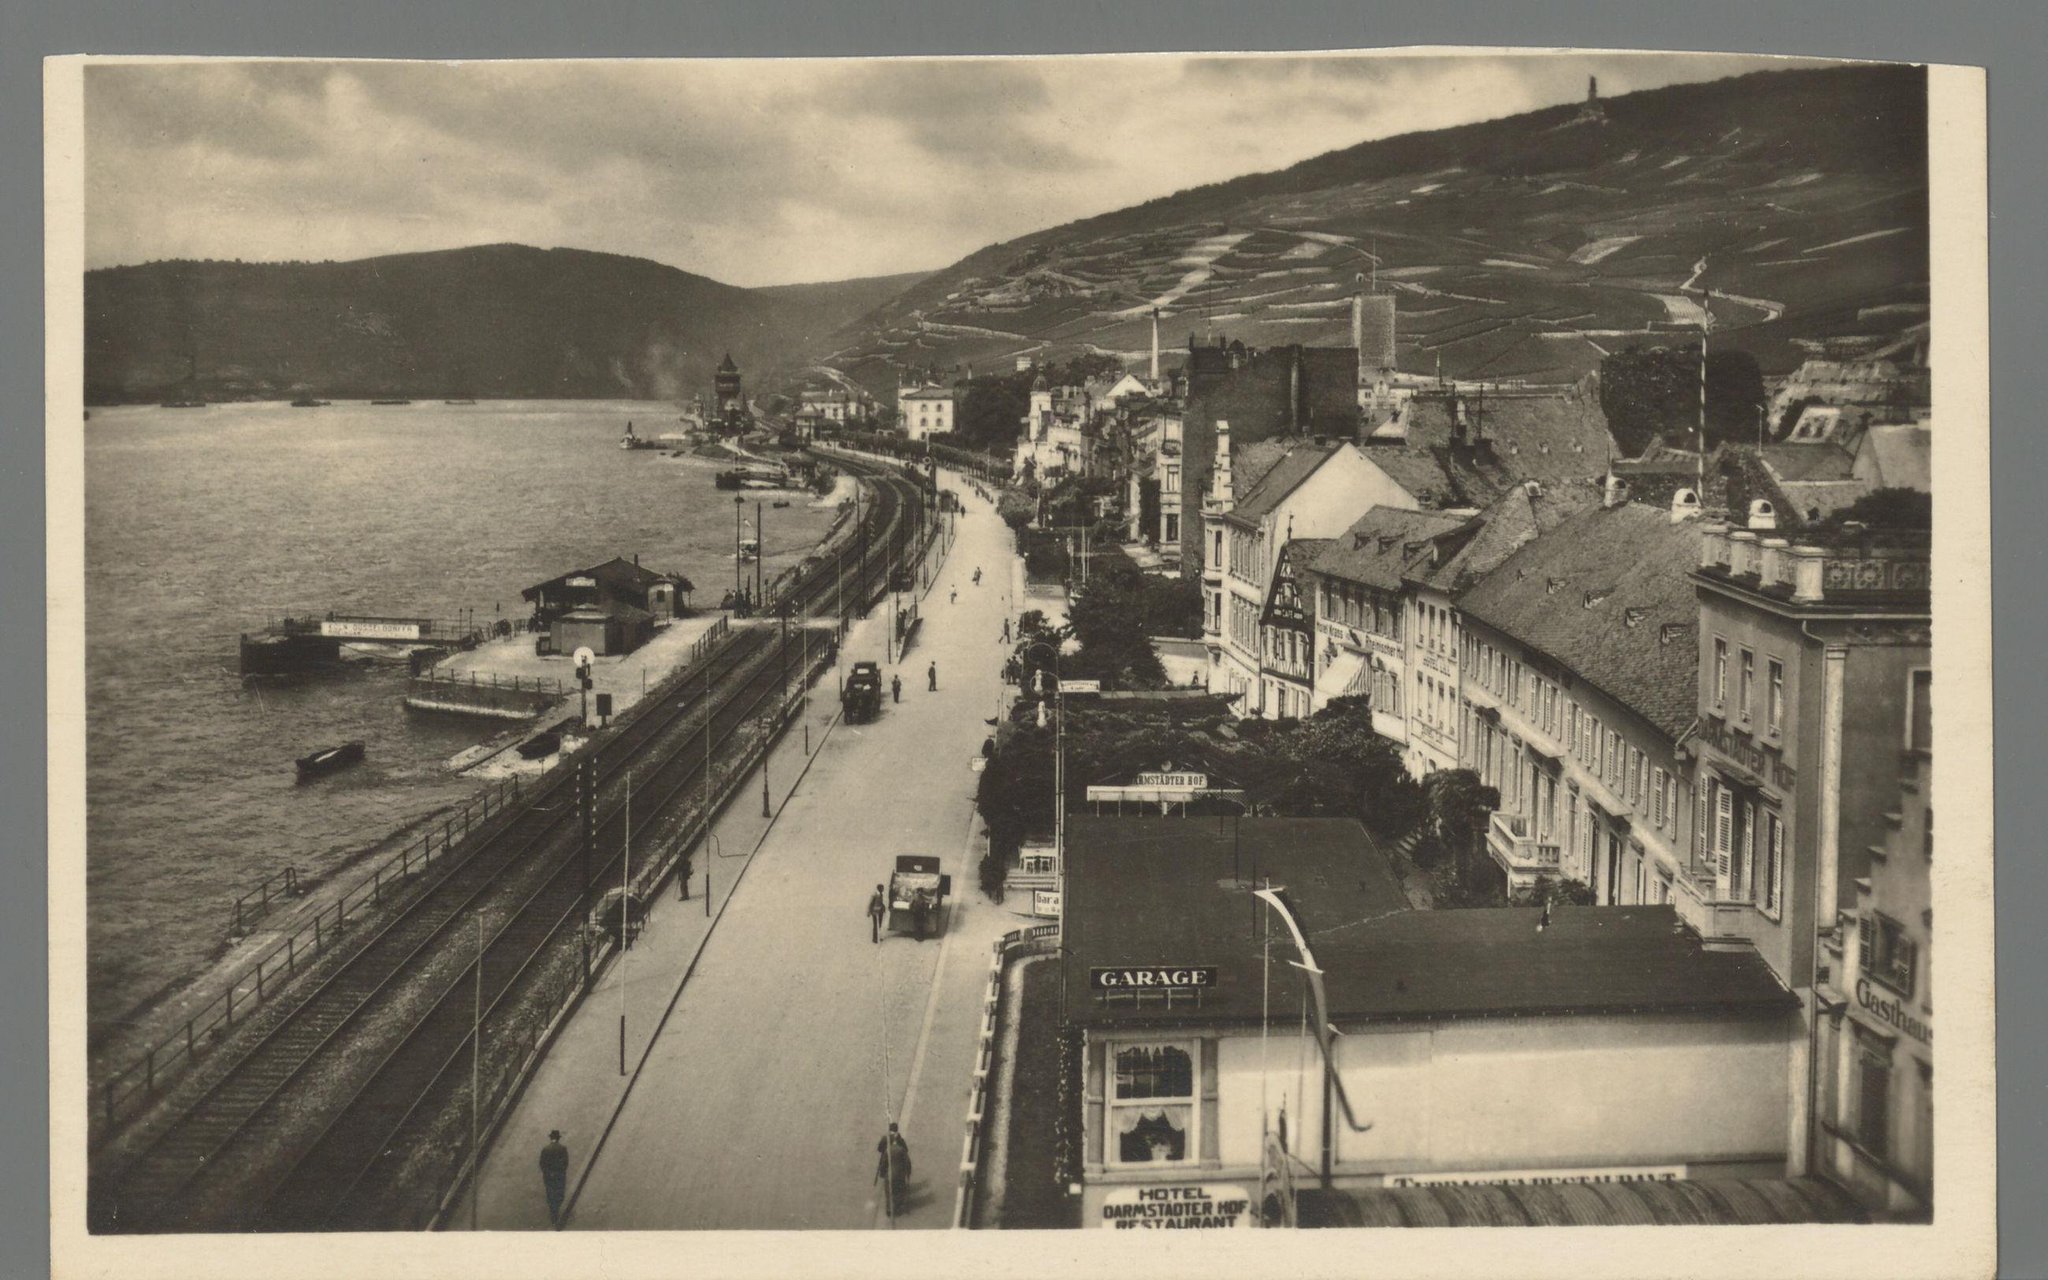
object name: ansichtkaart, prentbriefkaart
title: Blick auf Rüdesheim a. Rh.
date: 1905-1927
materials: photographic support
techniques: gelatin silver print, writing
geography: heidelberg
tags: river, quay